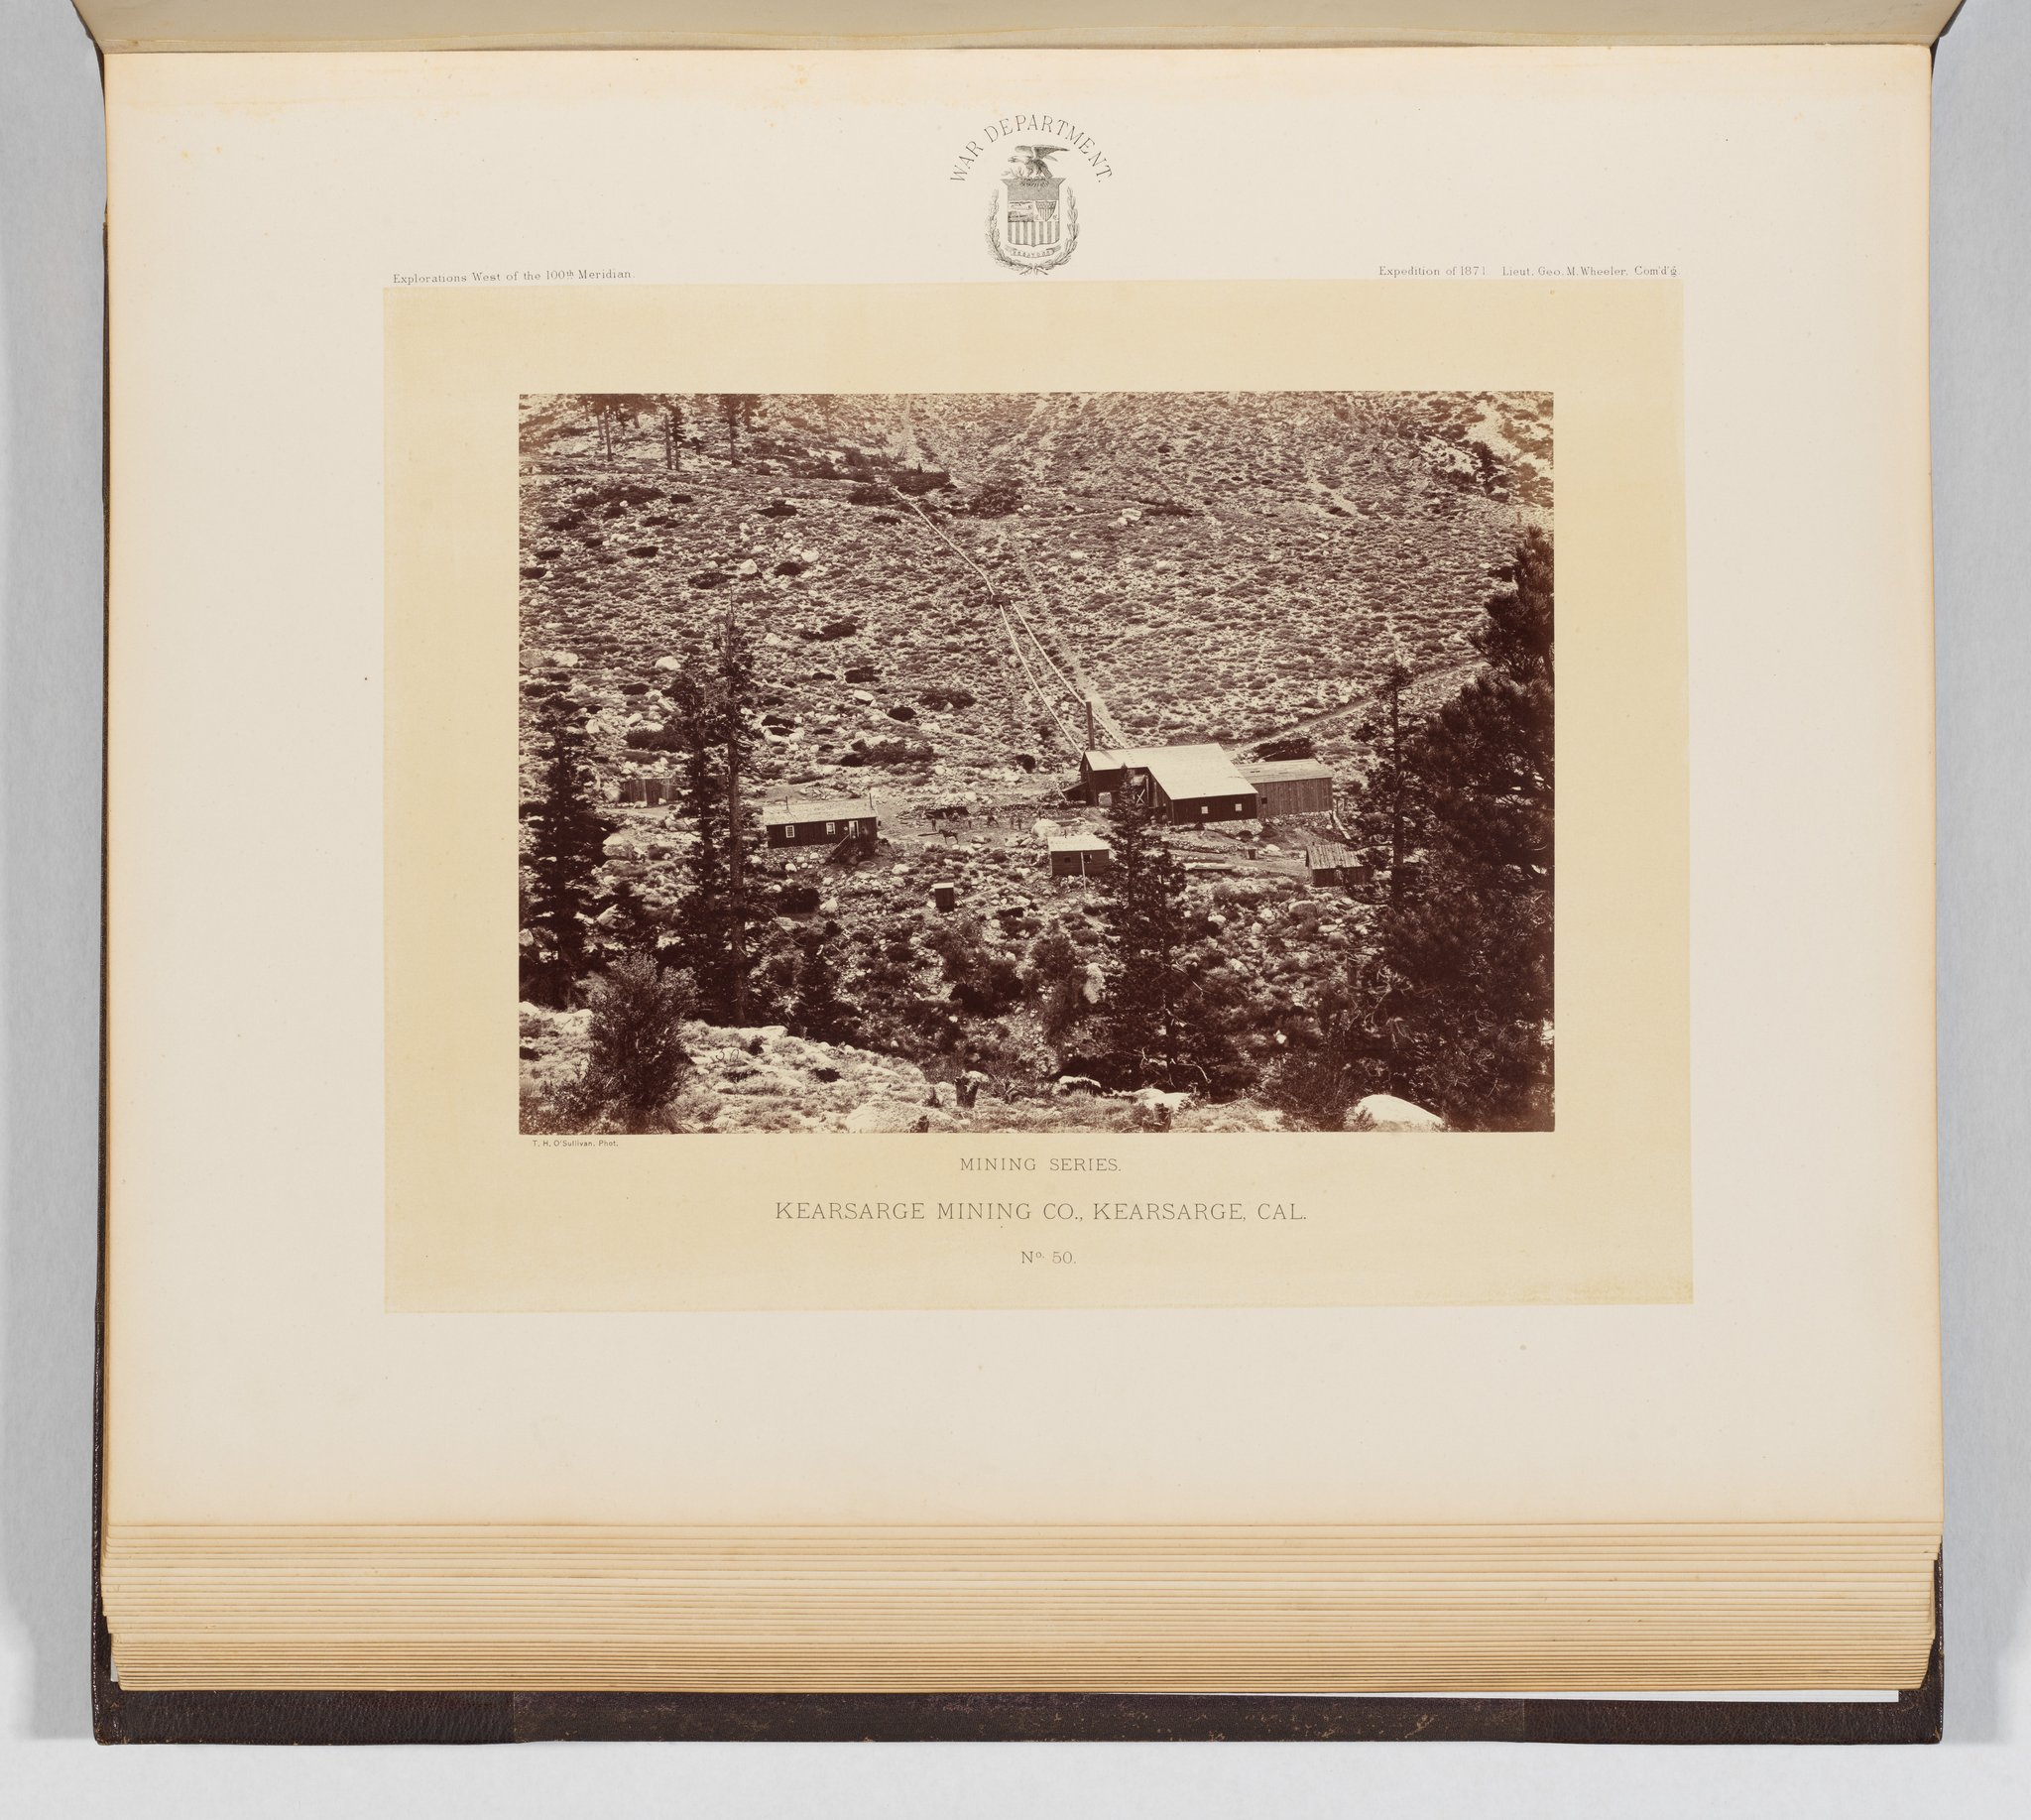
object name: photograph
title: Kearsarge Mining Company, Kearsarge, California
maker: timothy h. o'sullivan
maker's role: artist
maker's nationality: american, born ireland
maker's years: 1840-1882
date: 1871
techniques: albumen silver print, glass negative